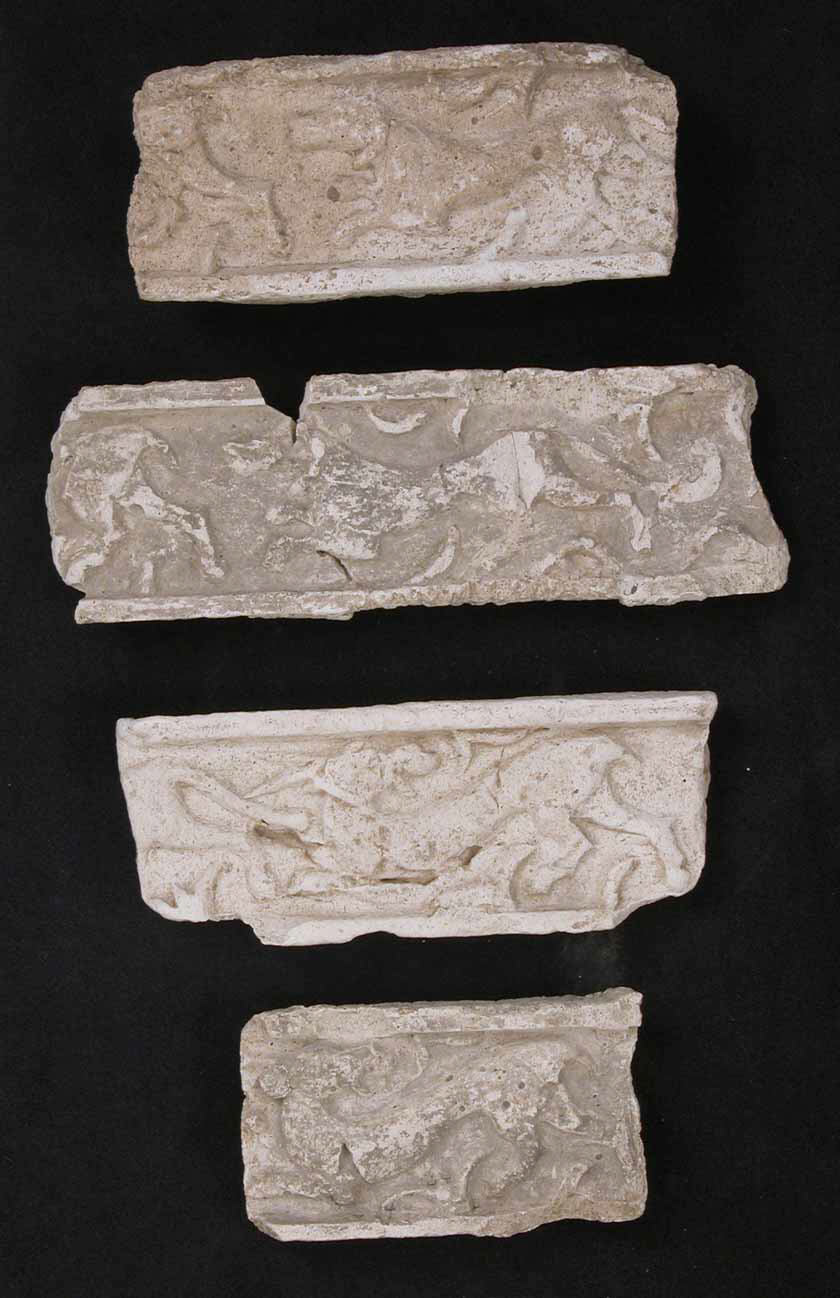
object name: frieze fragment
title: Fragments of a Frieze with Chasing Animals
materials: plaster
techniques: carving, molding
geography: turkey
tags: animals